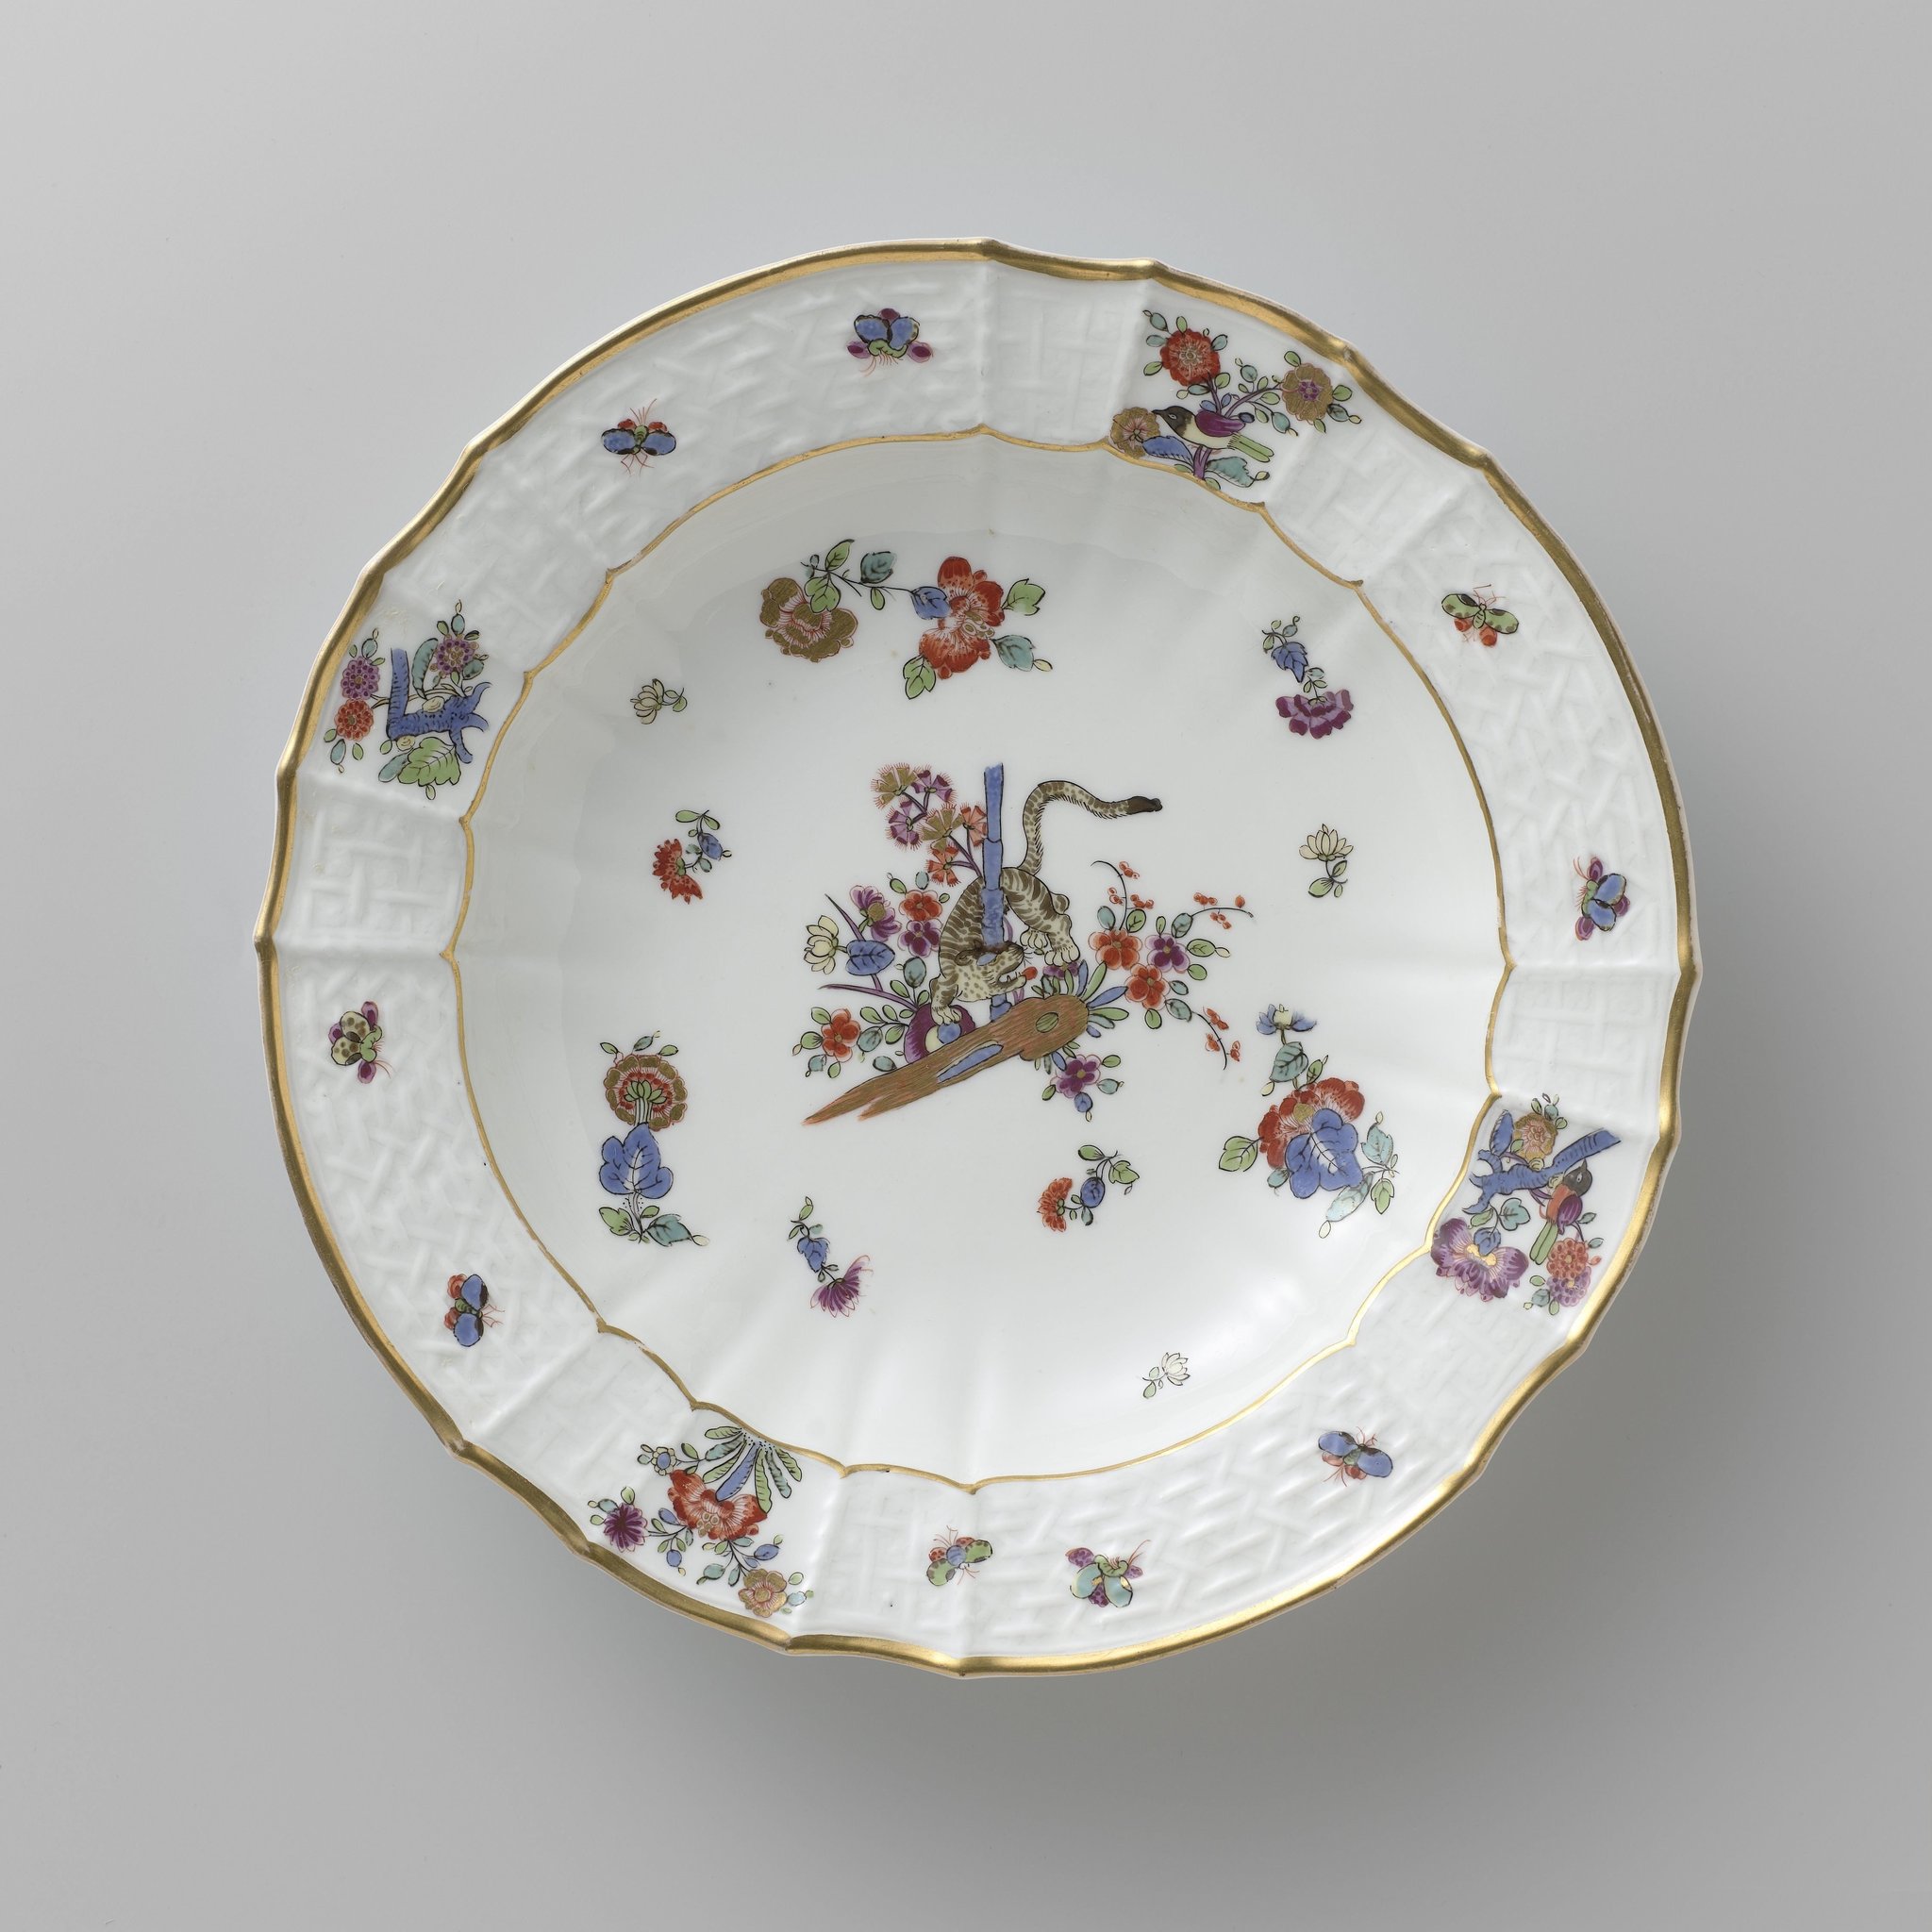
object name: soup plate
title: Soepbord, veelkleurig beschilderd met een Kakiemon-decor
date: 1740-1745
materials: porcelain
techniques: painted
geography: meissen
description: Soepbord van beschilderd porselein. Het bord heeft een geribde en geschulpte rand. Het bord is beschilderd met een tijger, die zich tussen bloemen om een bamboestengel draait, gestrooide Indianische Blumen, vlinders en takken met vogels. De rand is versierd met het 'Altbrandenstein'-patroon. Het bord is gemerkt.